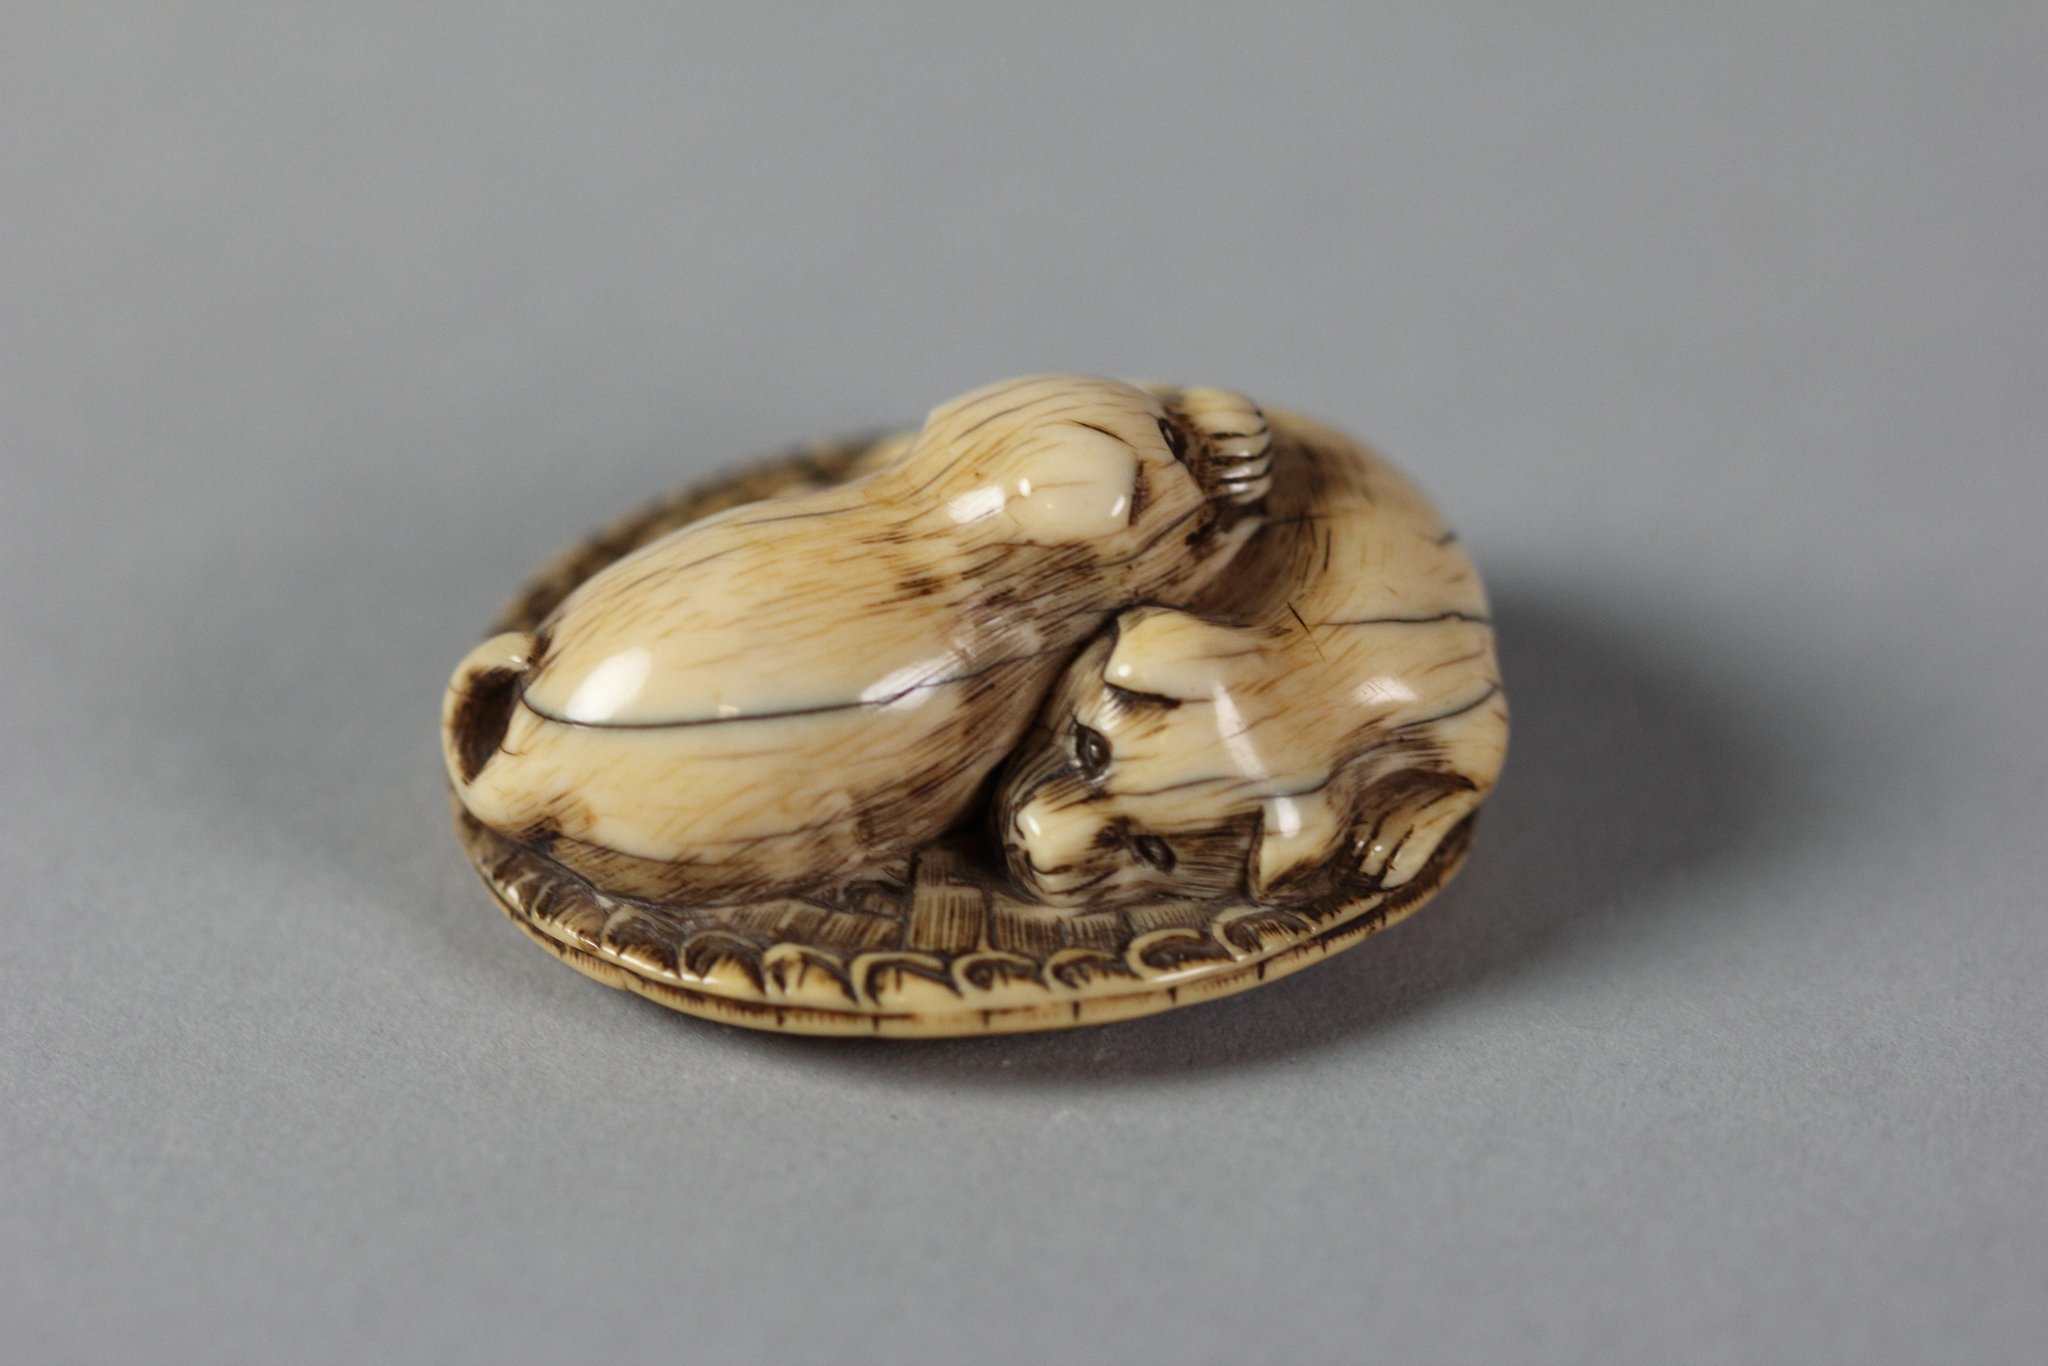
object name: netsuke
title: Netsuke of Two Dogs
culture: japanese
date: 1801-1900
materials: ivory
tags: dogs